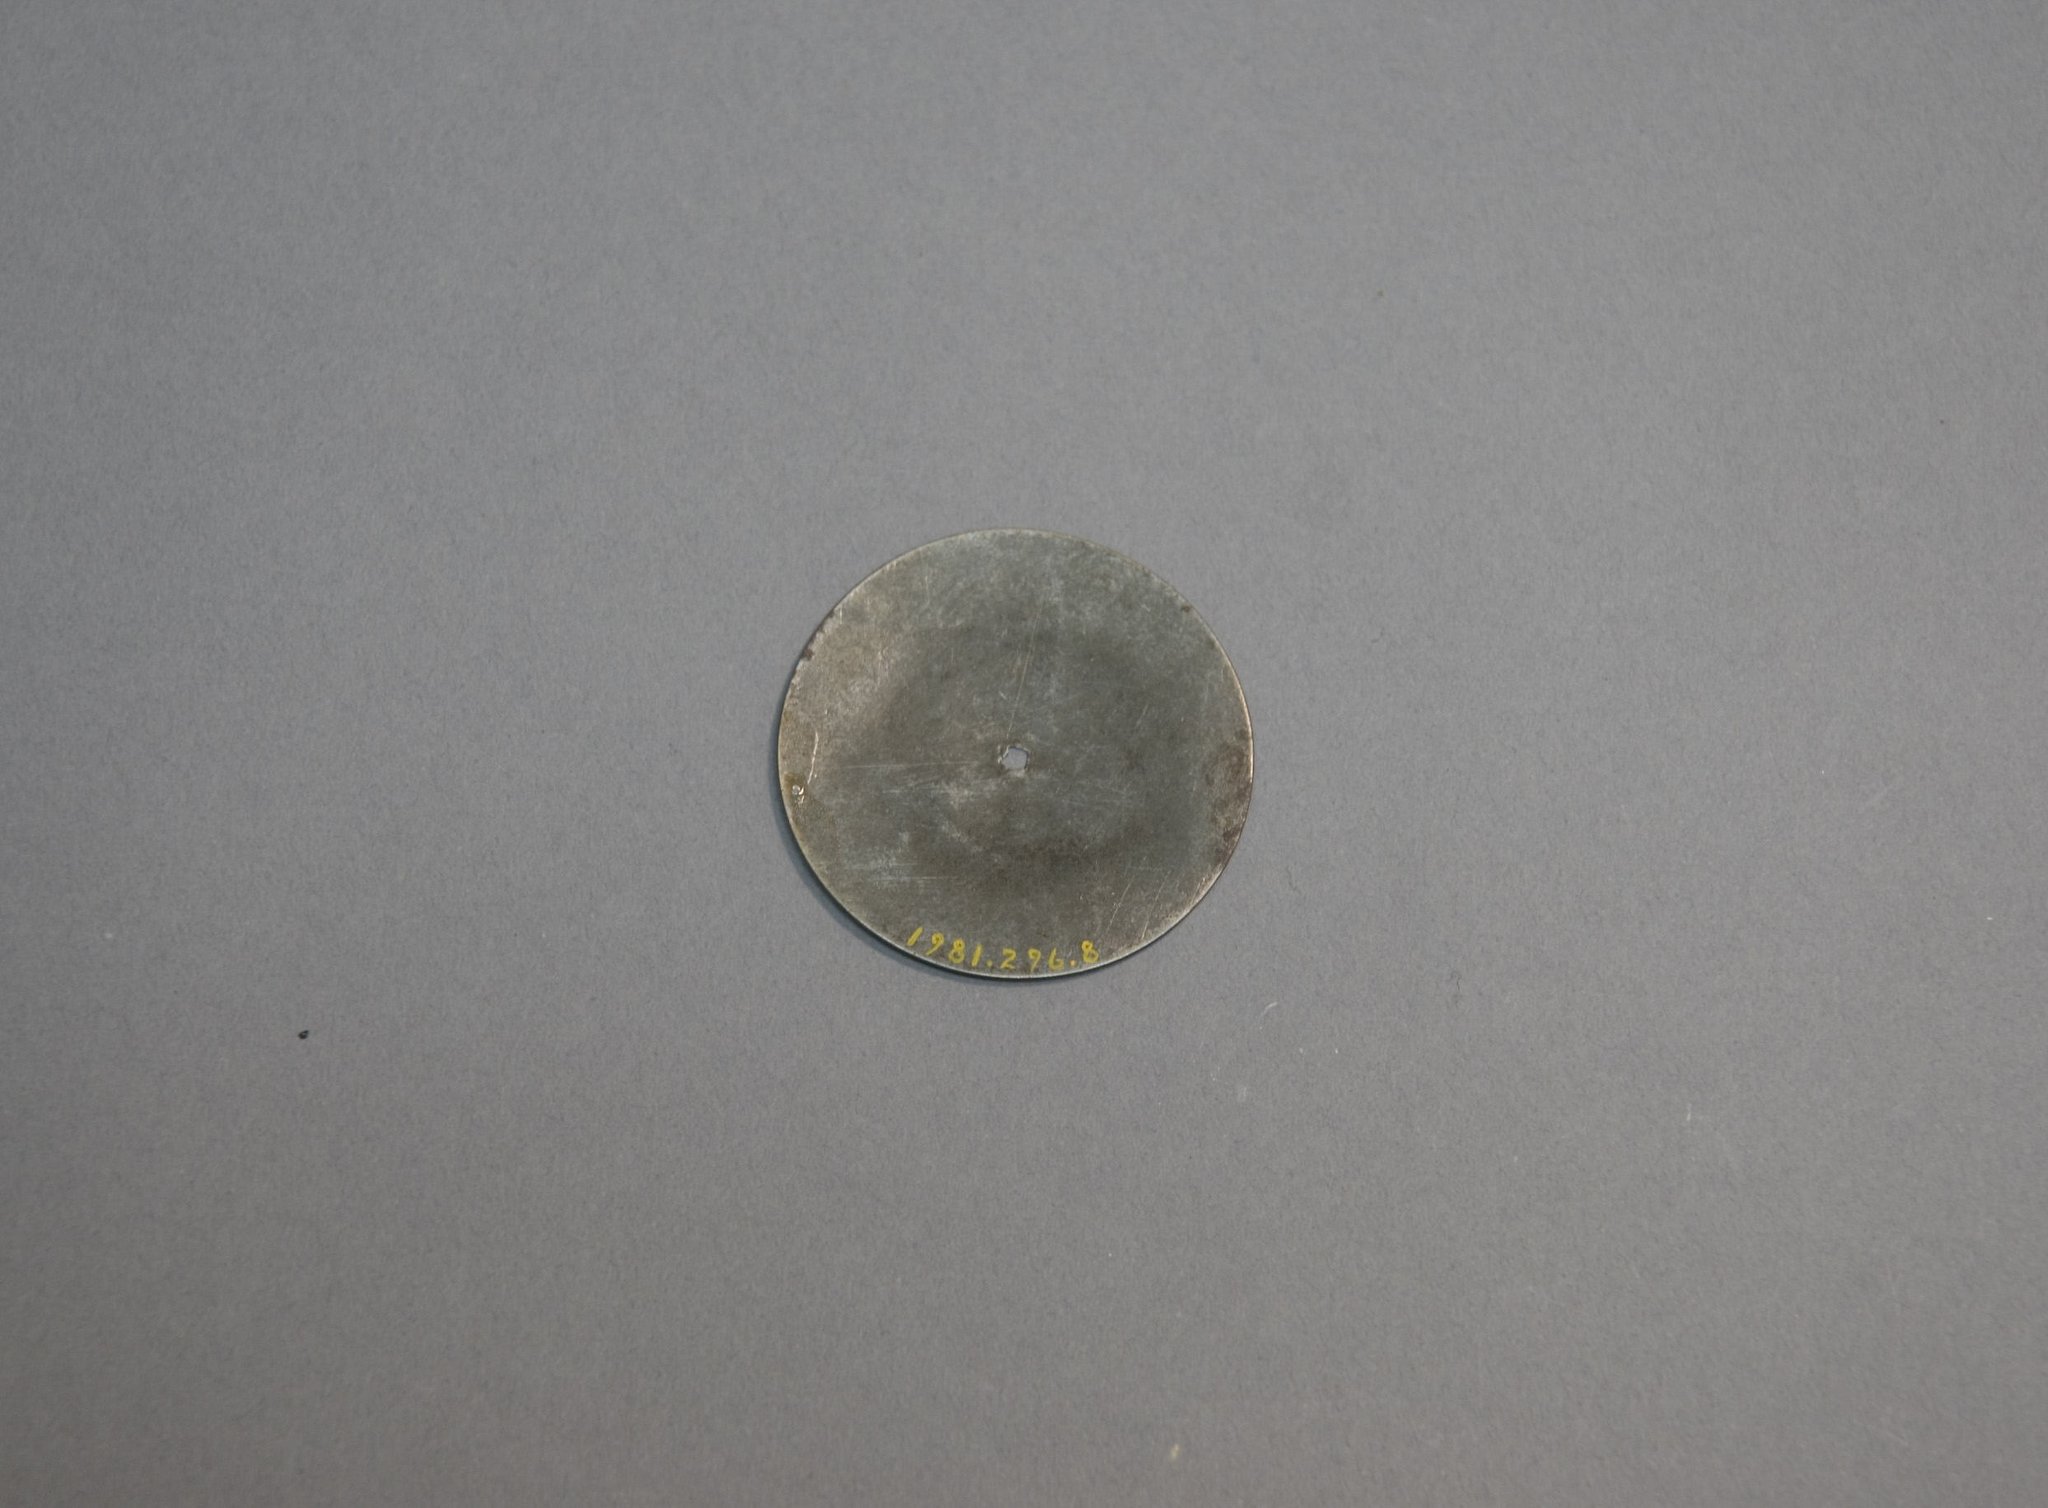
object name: jade carving tool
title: Small Grinder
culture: chinese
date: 1901-2000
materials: metal